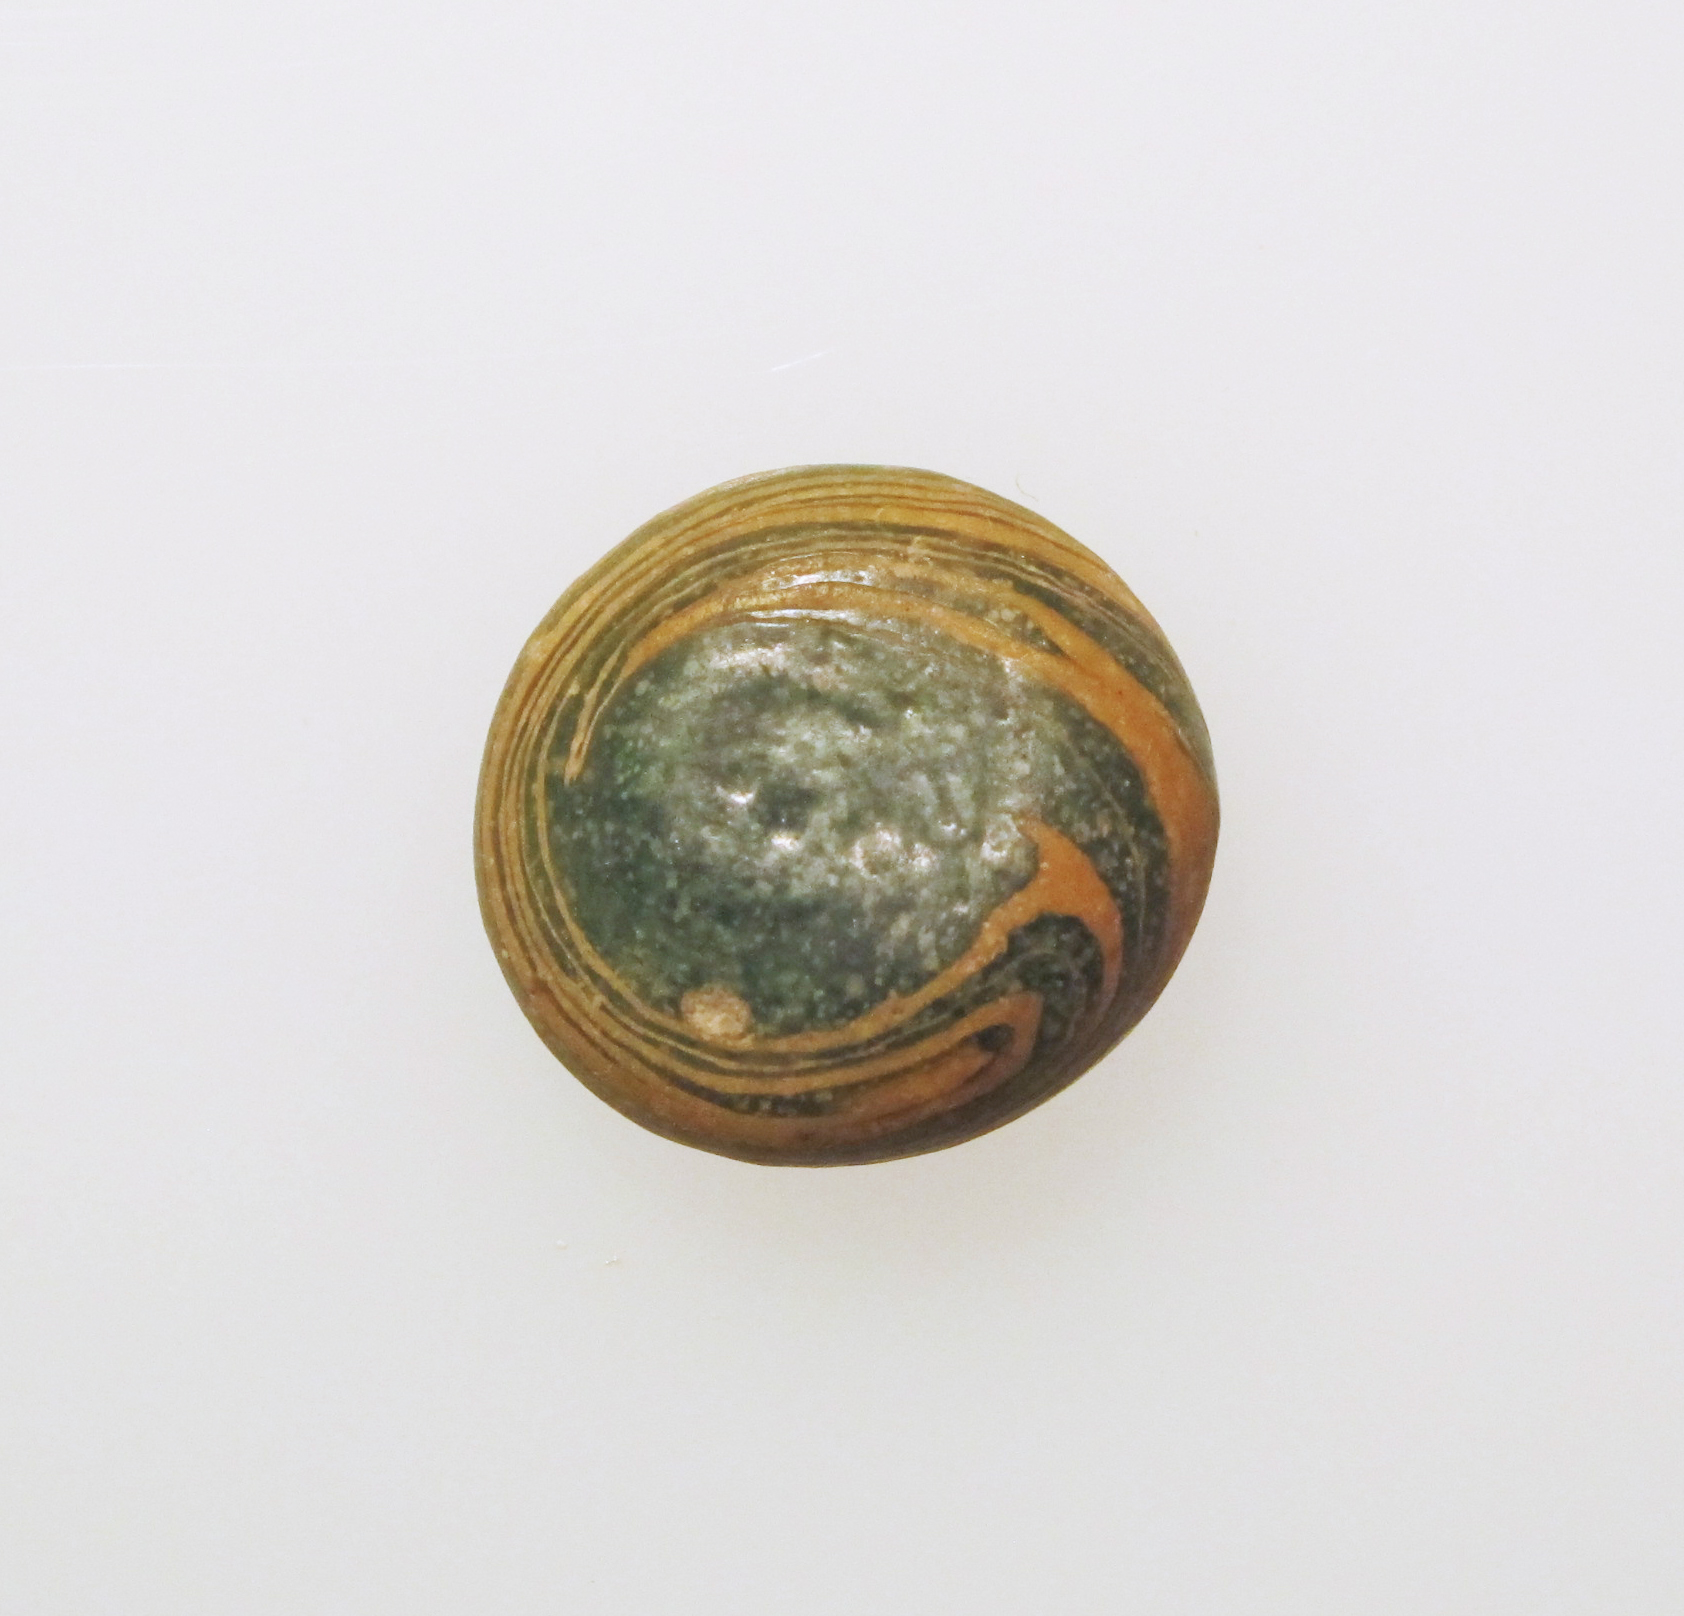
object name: pinhead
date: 7000 BCE-330 CE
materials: glass